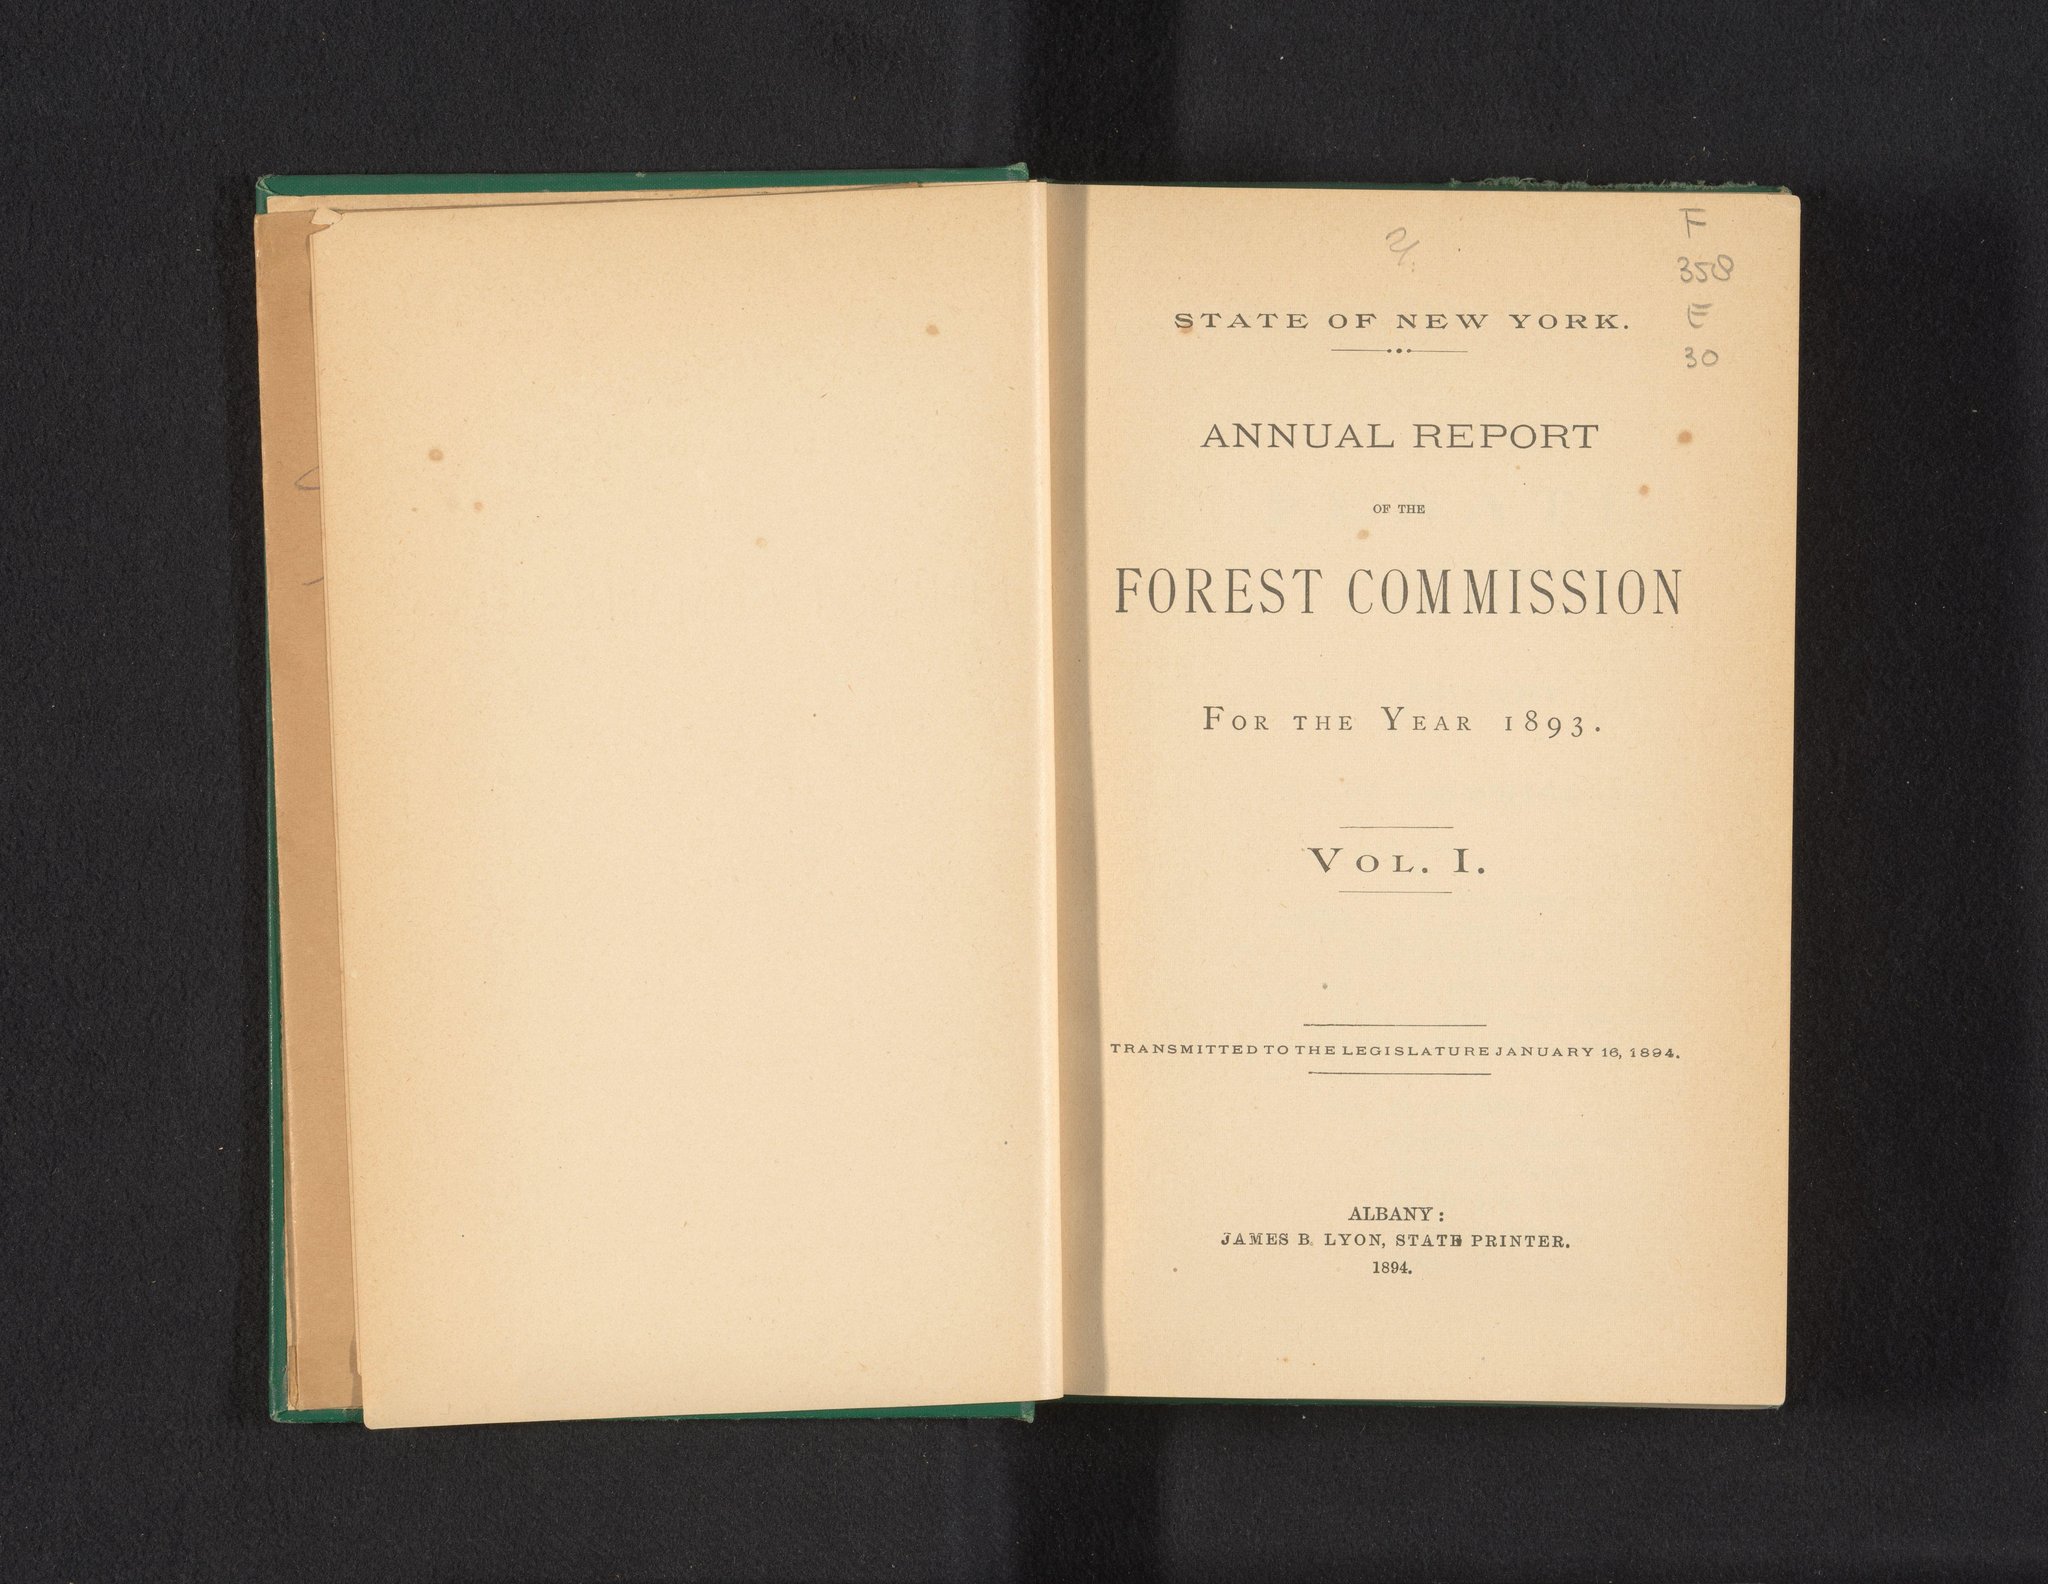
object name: book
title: Annual report of the Forest Commission of the State of New York for the year ending December 31, 1893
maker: james b. lyon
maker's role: printer, publisher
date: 1894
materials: cardboard, linen, paper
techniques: photograph, lithograph, printing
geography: albany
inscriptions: inscription: ‘Walter H Harrison Lebanon Spgs, N.Y.’, inscription: ‘compliments of of Saint [...]ilden’